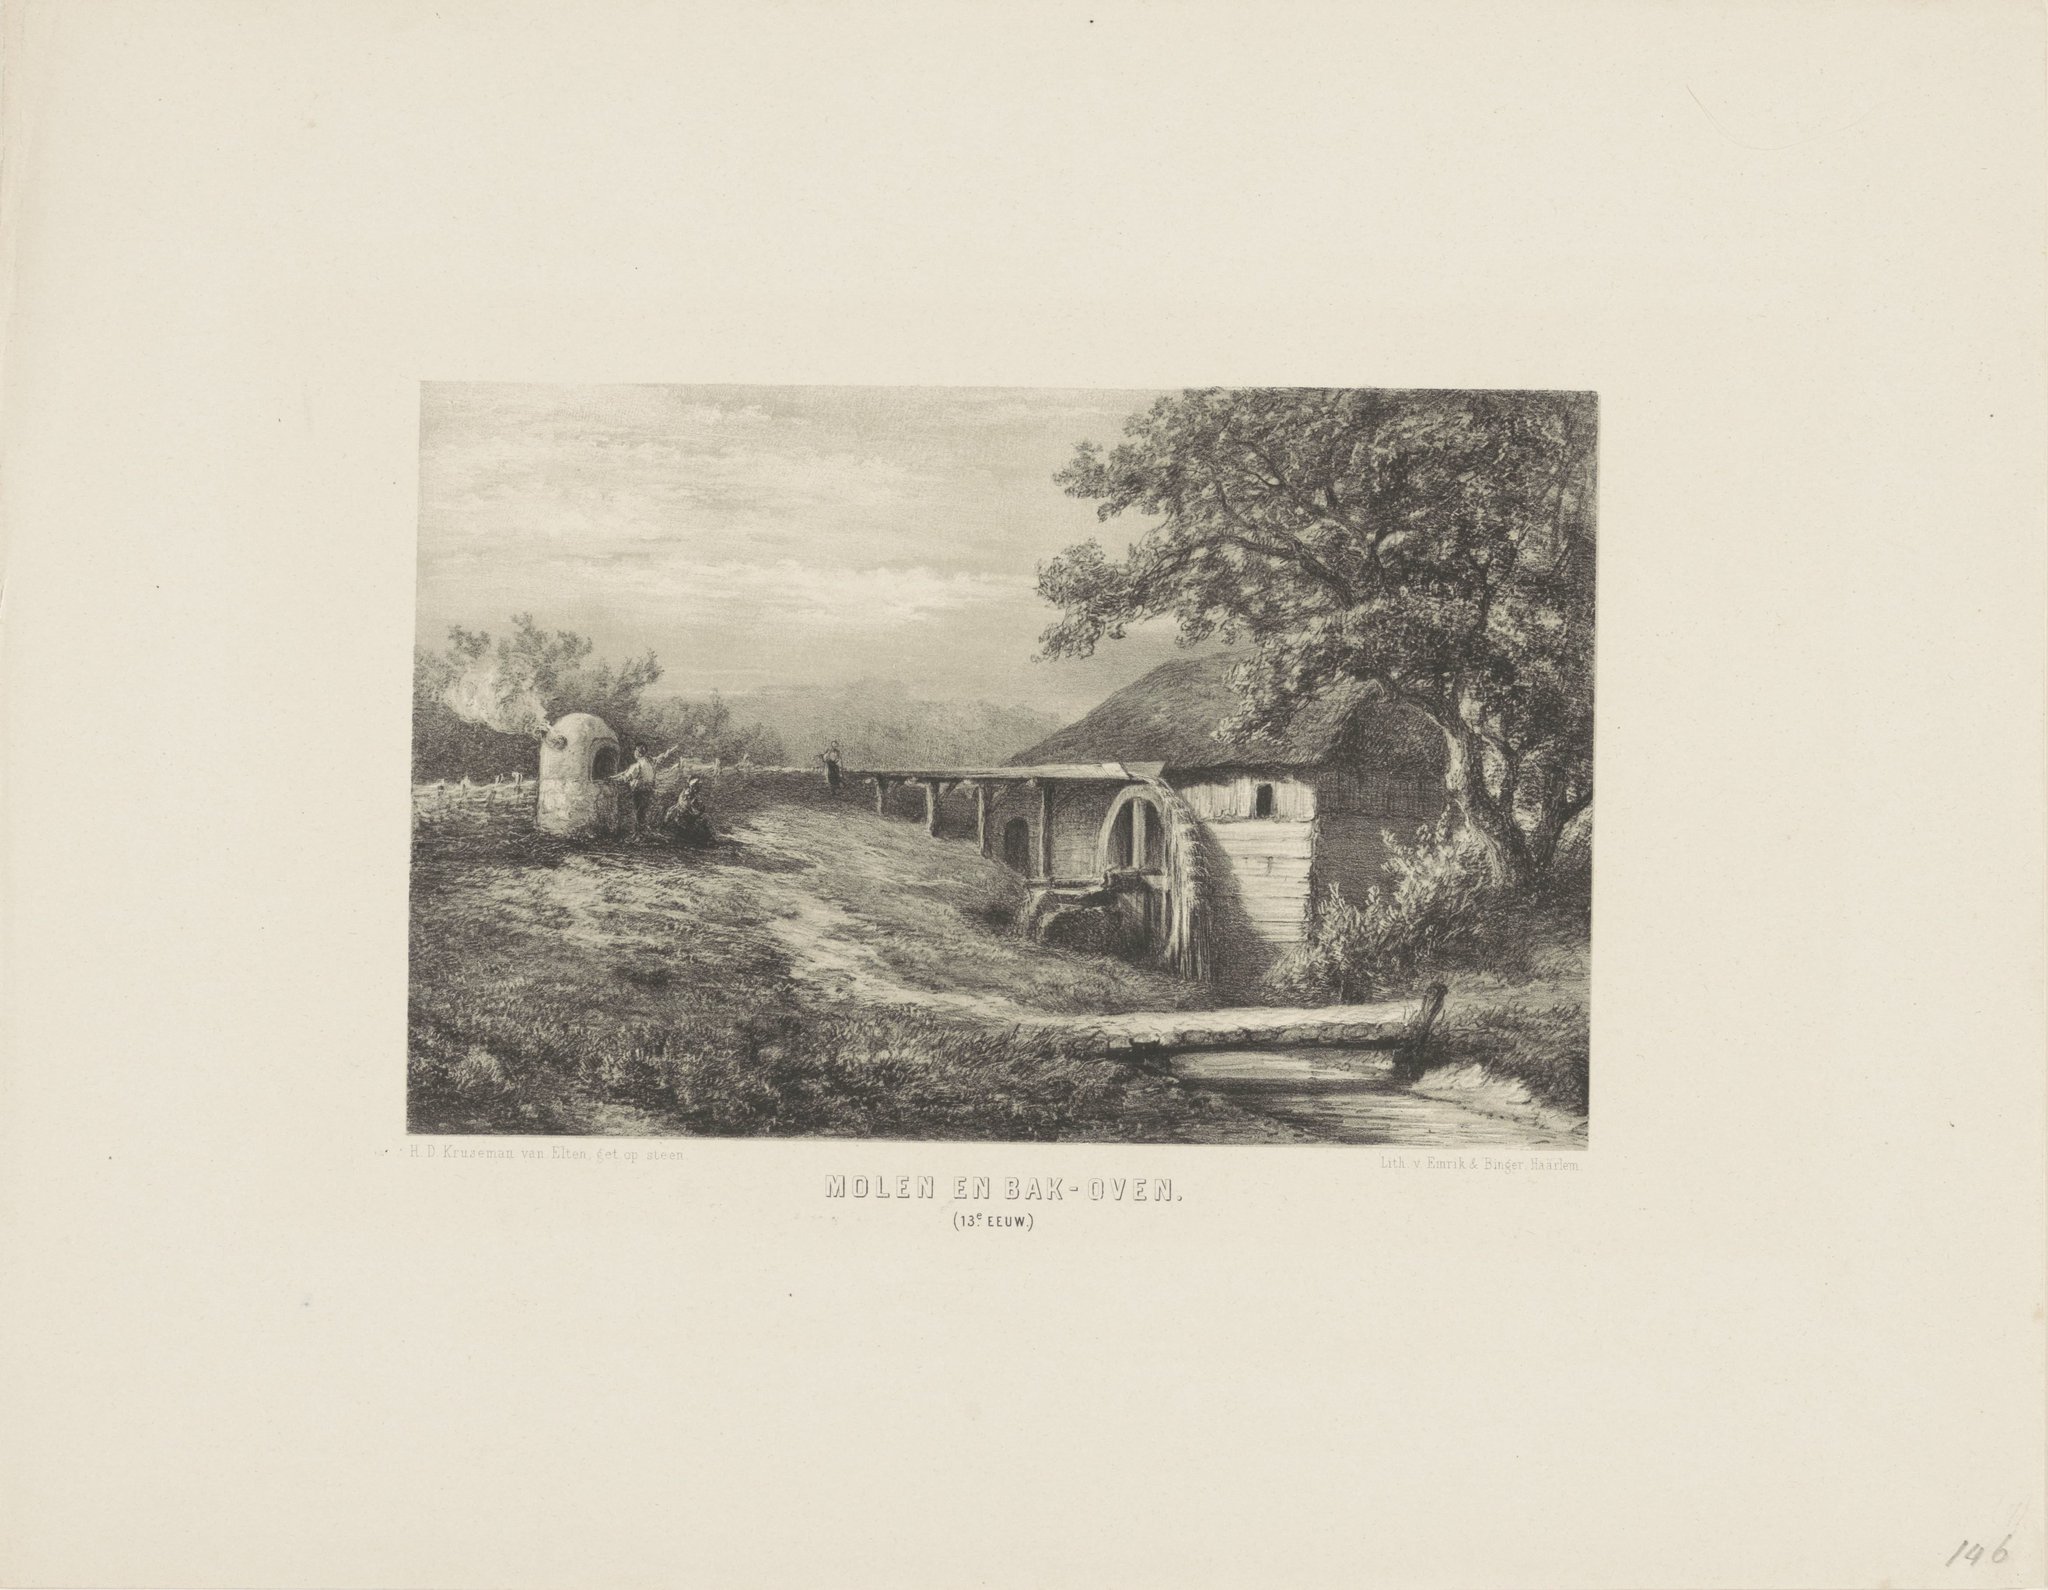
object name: print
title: Watermolen en bakoven, 13e eeuw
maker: hendrik dirk kruseman van elten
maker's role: draughtsman, print maker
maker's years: 1829-1904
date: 1857-1864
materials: paper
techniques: tone lithography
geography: haarlem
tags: watermill, netherlands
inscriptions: collector's mark: Lugt 2228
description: Illustratie voor: W.J. Hofdijk, Ons voorgeslacht in zijn dagelyksch leven geschilderd, Kruseman, Haarlem 1859-1864.